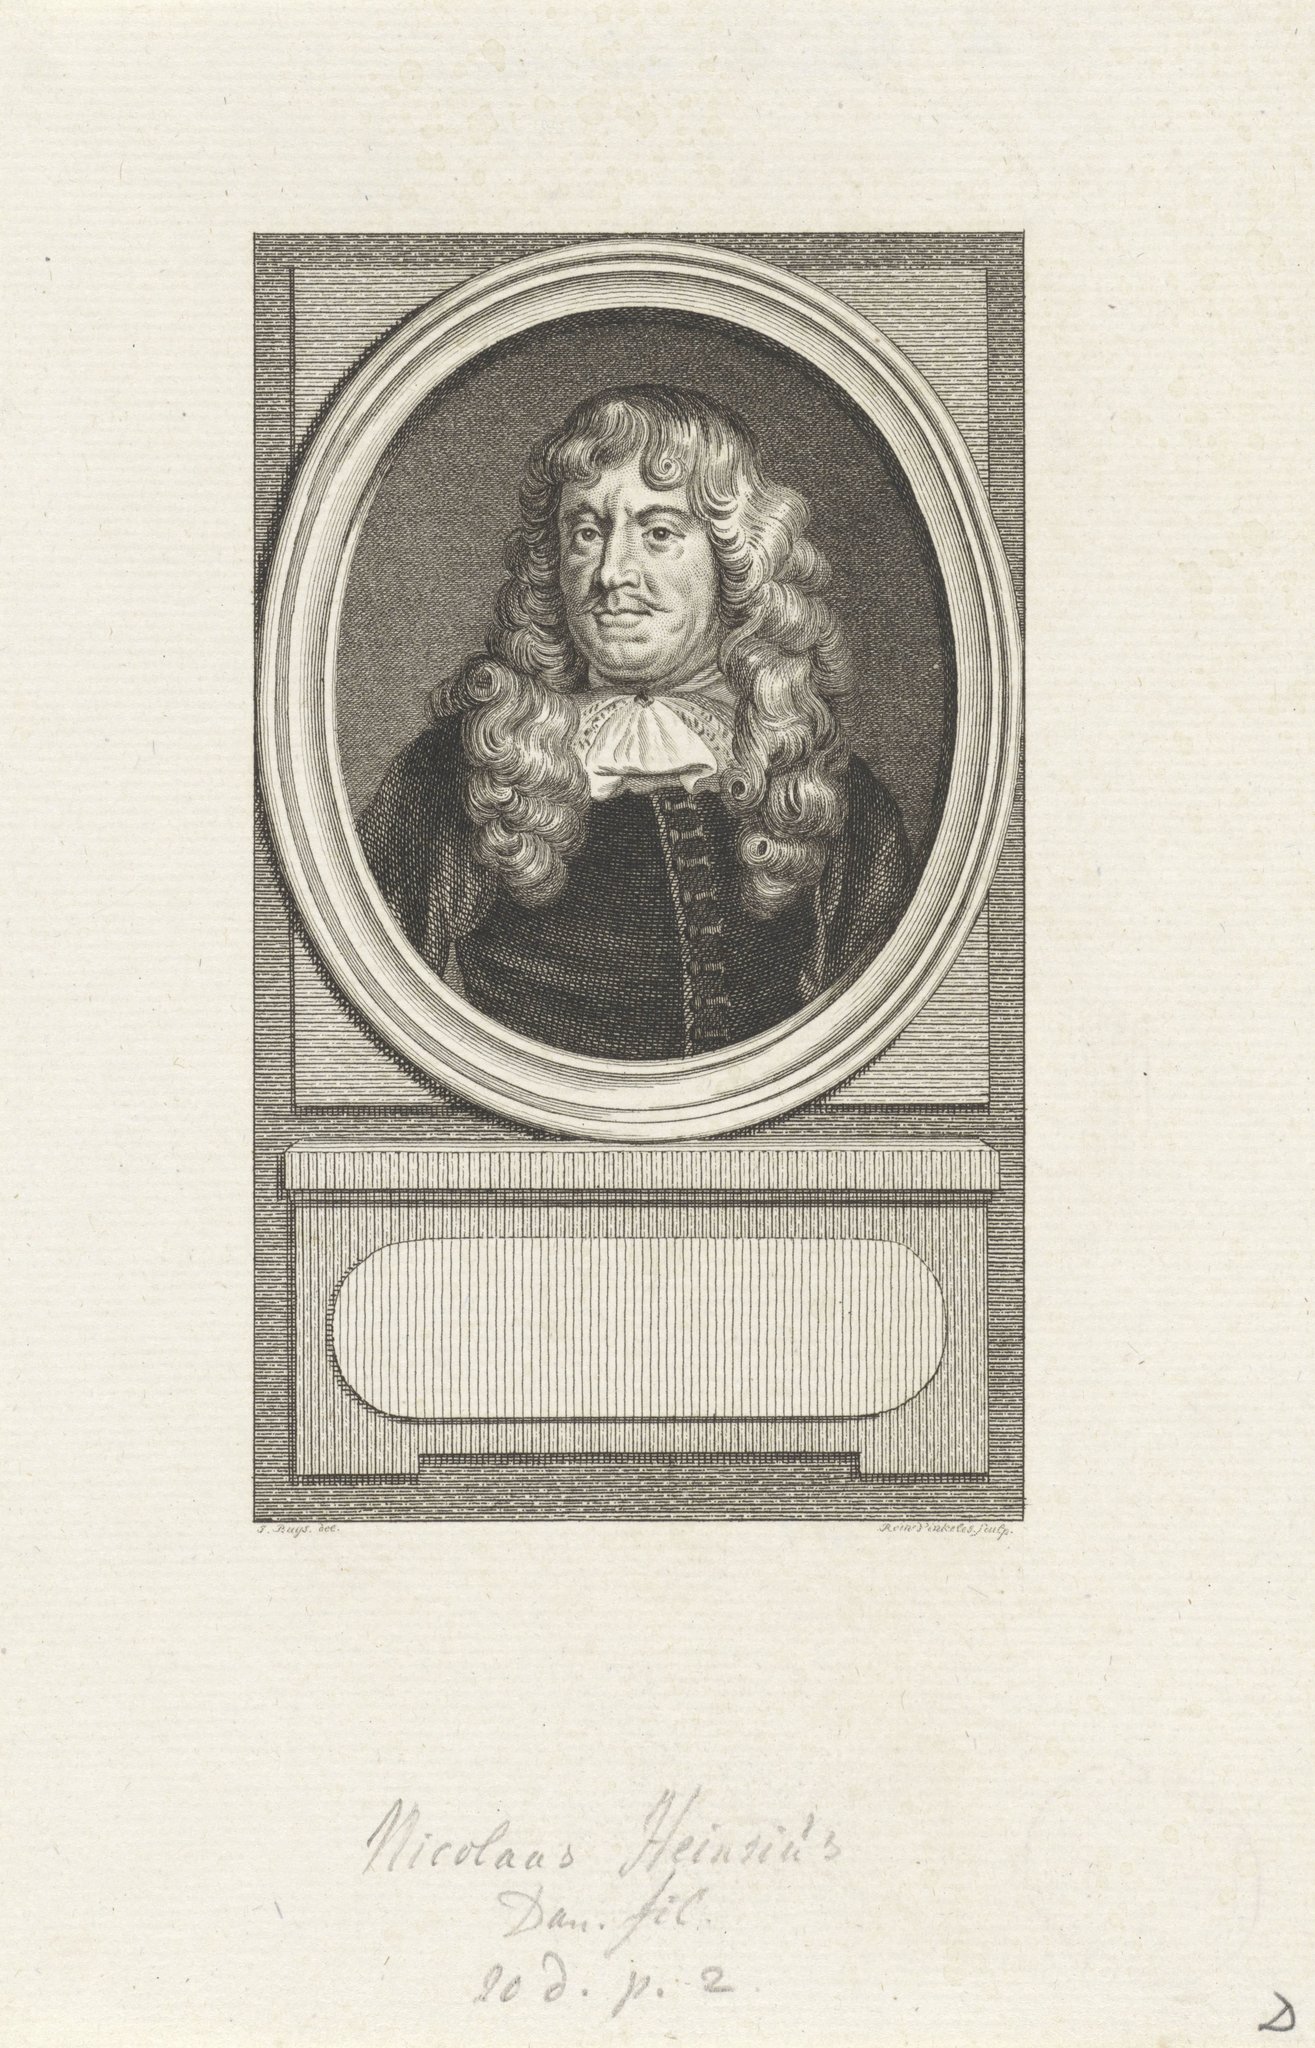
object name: print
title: Portret van Nicolaas Heinsius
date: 1789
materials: paper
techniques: etching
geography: amsterdam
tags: the hague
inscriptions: inscription: ‘Nicolaas Heinsius/ Dan. Fil. / 20 d. p. 2.’, collector's mark: Lugt 240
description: Latere staat prent gebruikt als boekillustratie in: Kok, Jacobus. Vaderlandsch woordenboek : met kaarten, plaaten en pourtraitten. Amsterdam: Johannes Allart, 1785-1796. Deel XX.